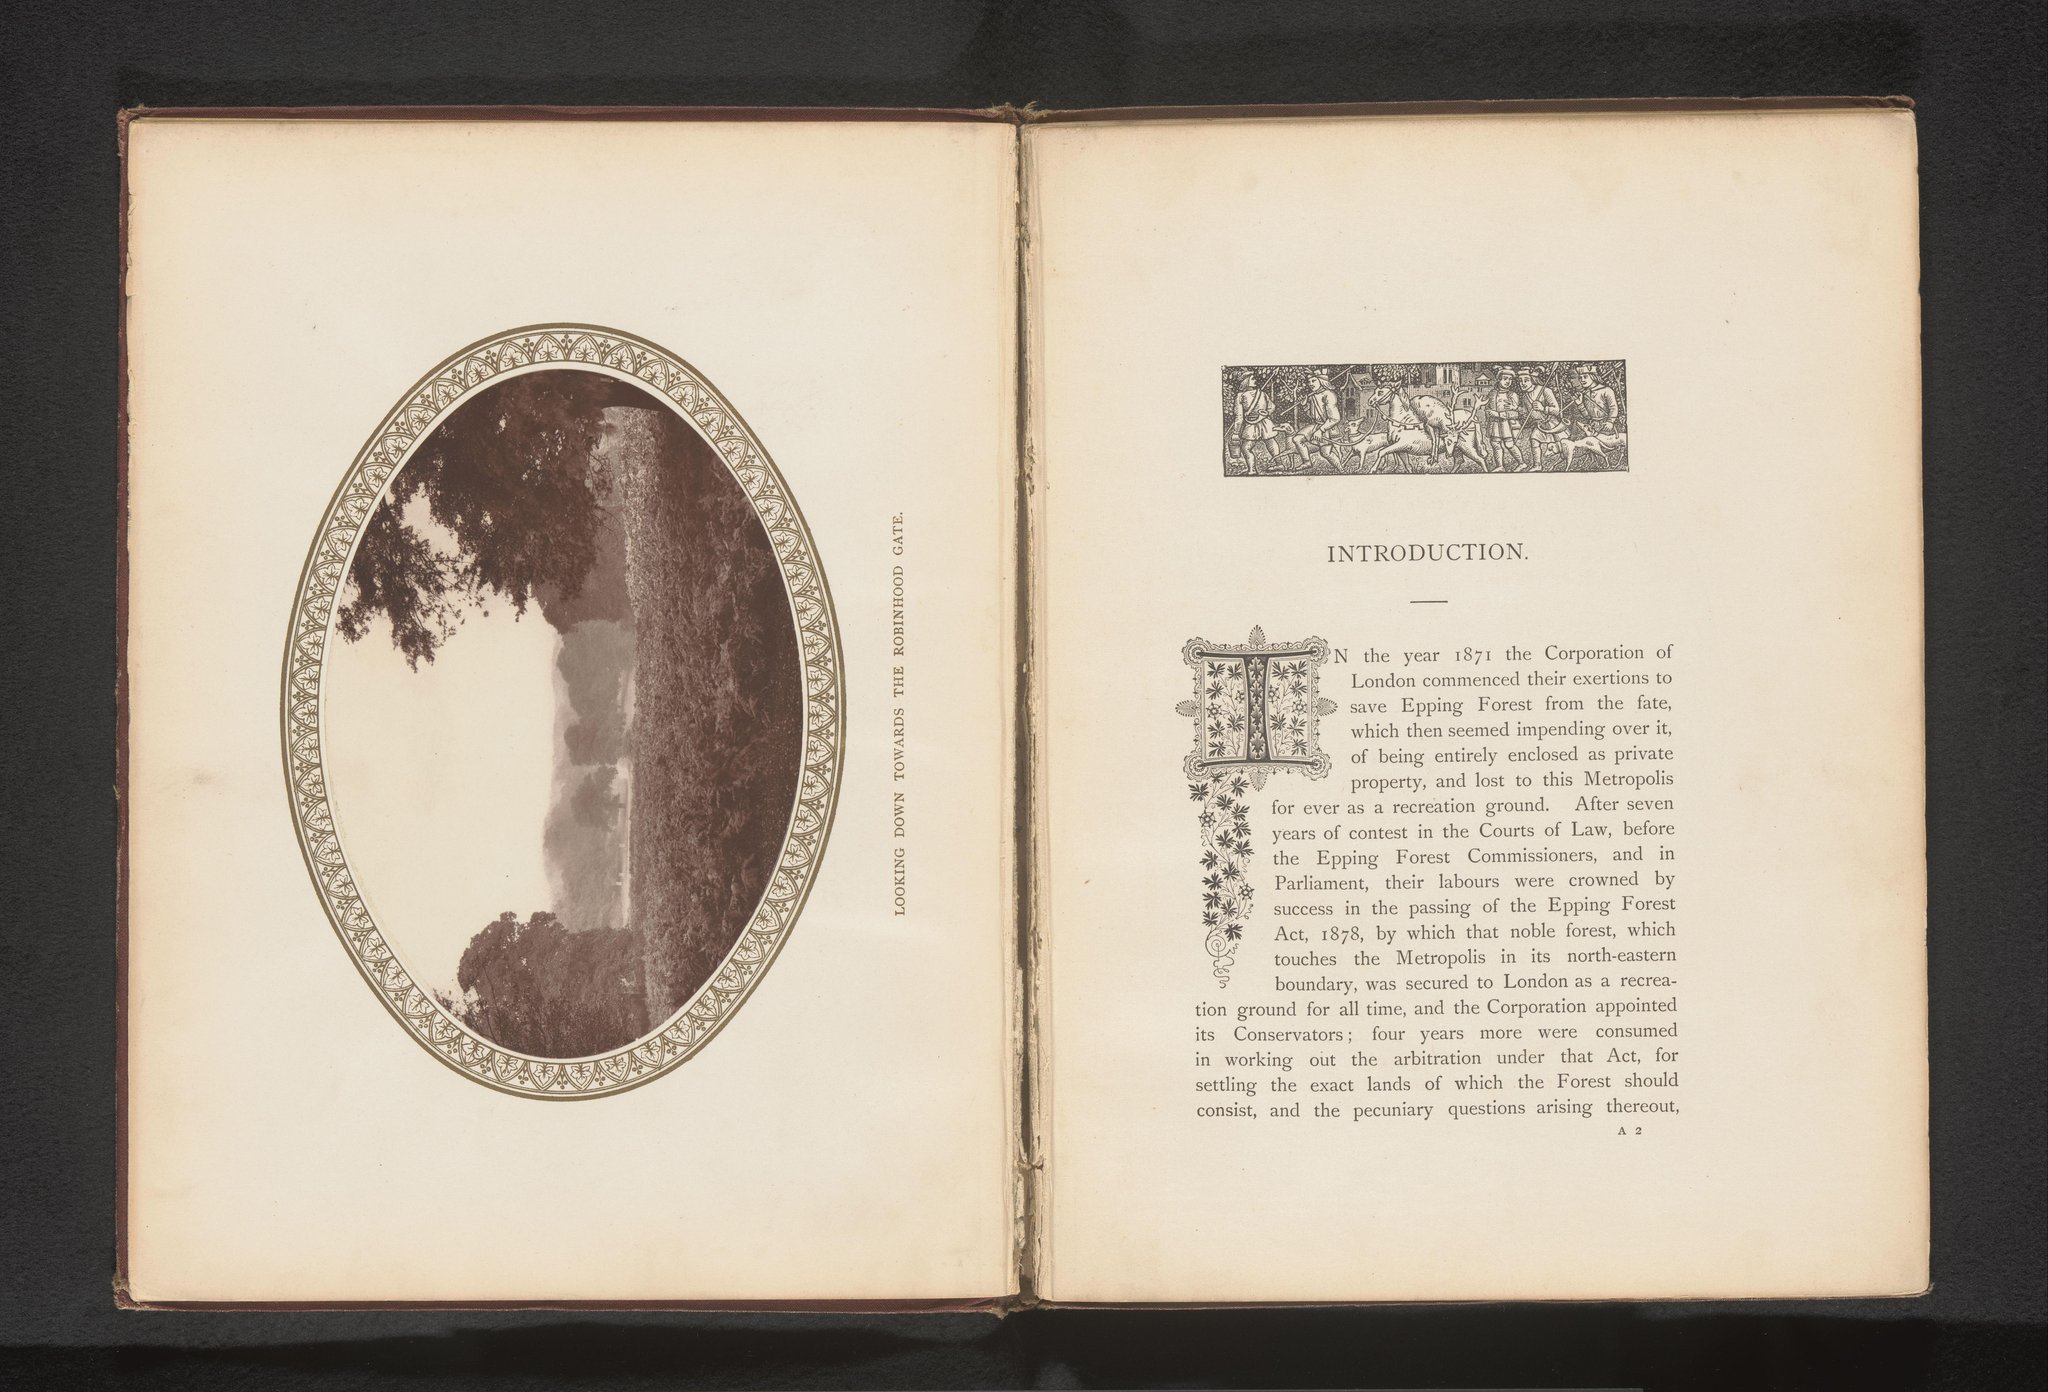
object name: page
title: Looking down towards the Robinhood Gate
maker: Anonymous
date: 1879-1889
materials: paper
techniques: woodburytype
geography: richmond park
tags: public gardens, park